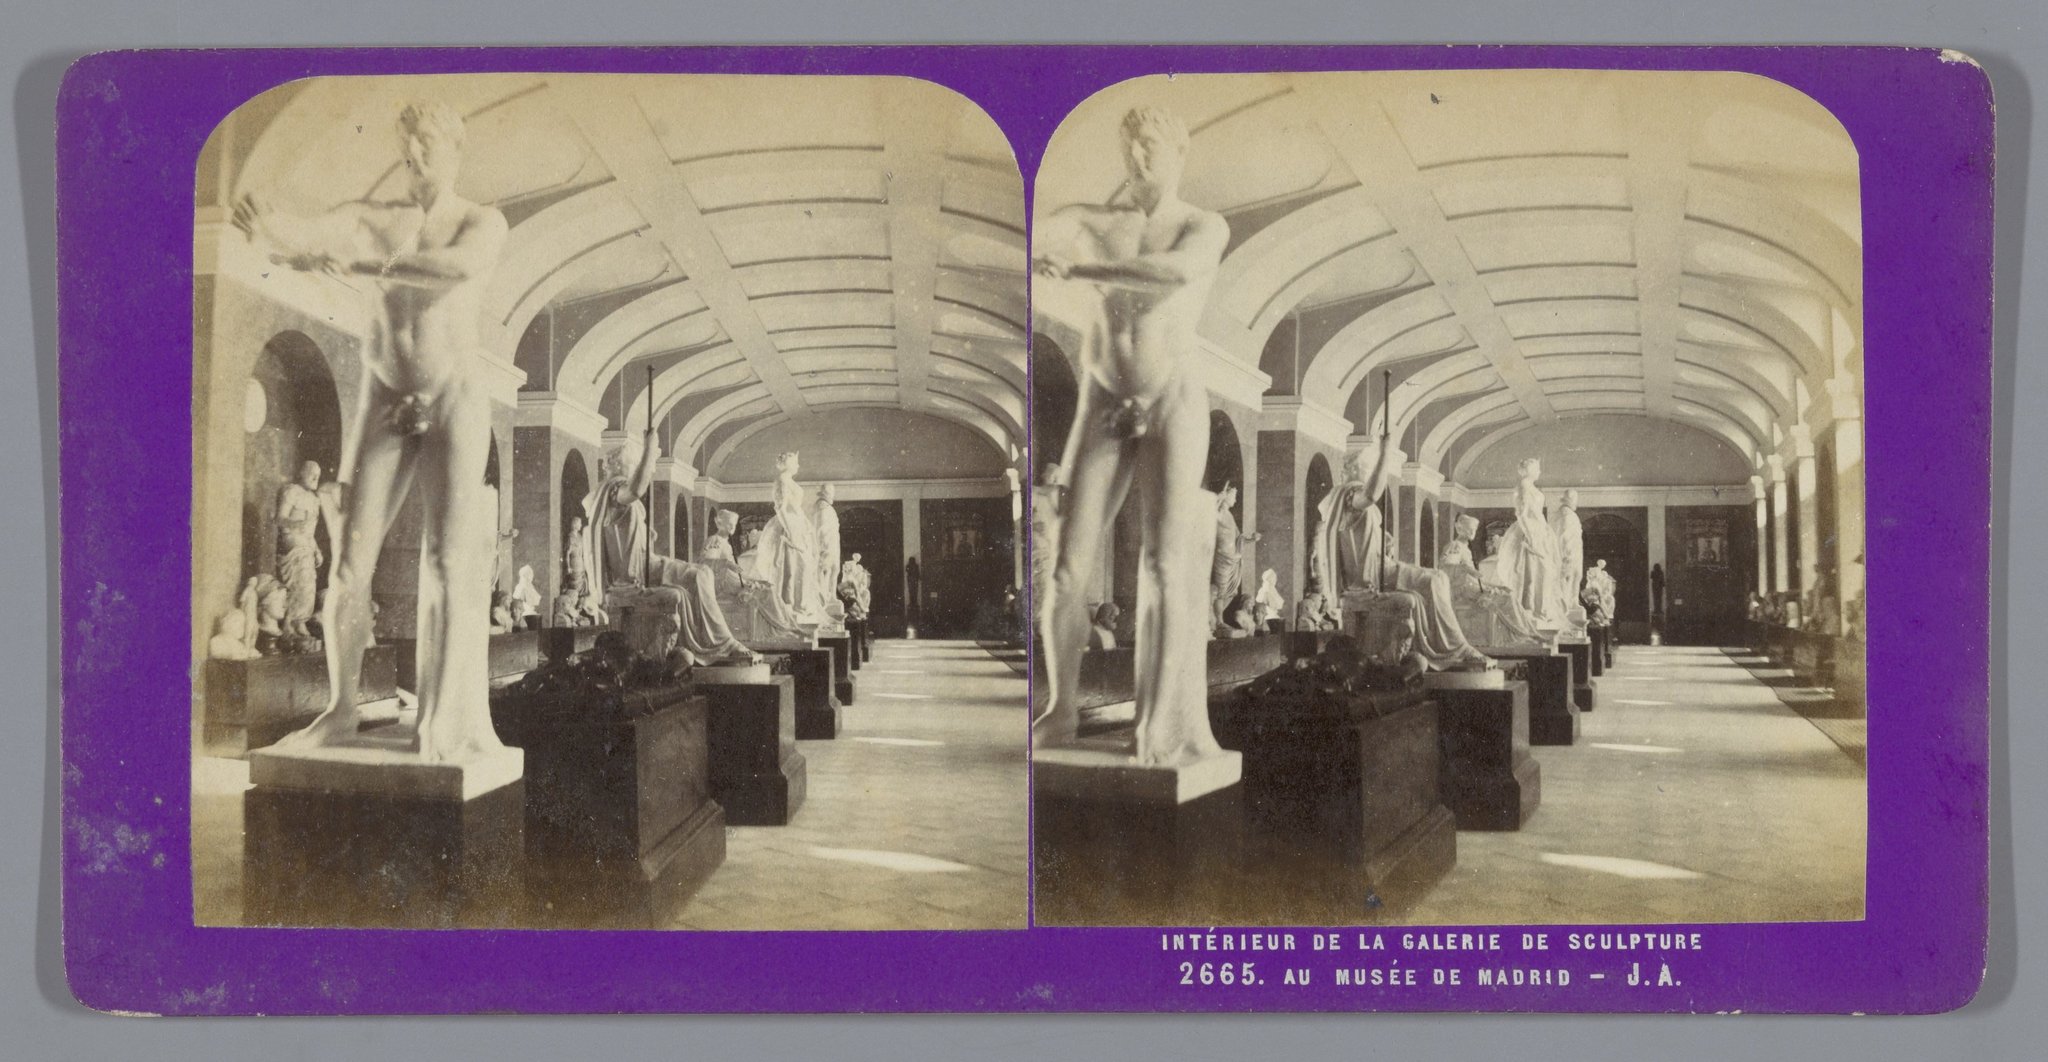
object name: stereograph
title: Beeldengalerij in het Museo Nacional del Prado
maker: jean andrieu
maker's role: fotograaf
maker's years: 1816-1872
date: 1862-1876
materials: cardboard, photographic support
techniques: albumen print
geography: museo nacional del prado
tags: gallery of sculptures, sculpture, interior ~ representation of a building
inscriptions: number: ‘2665.’